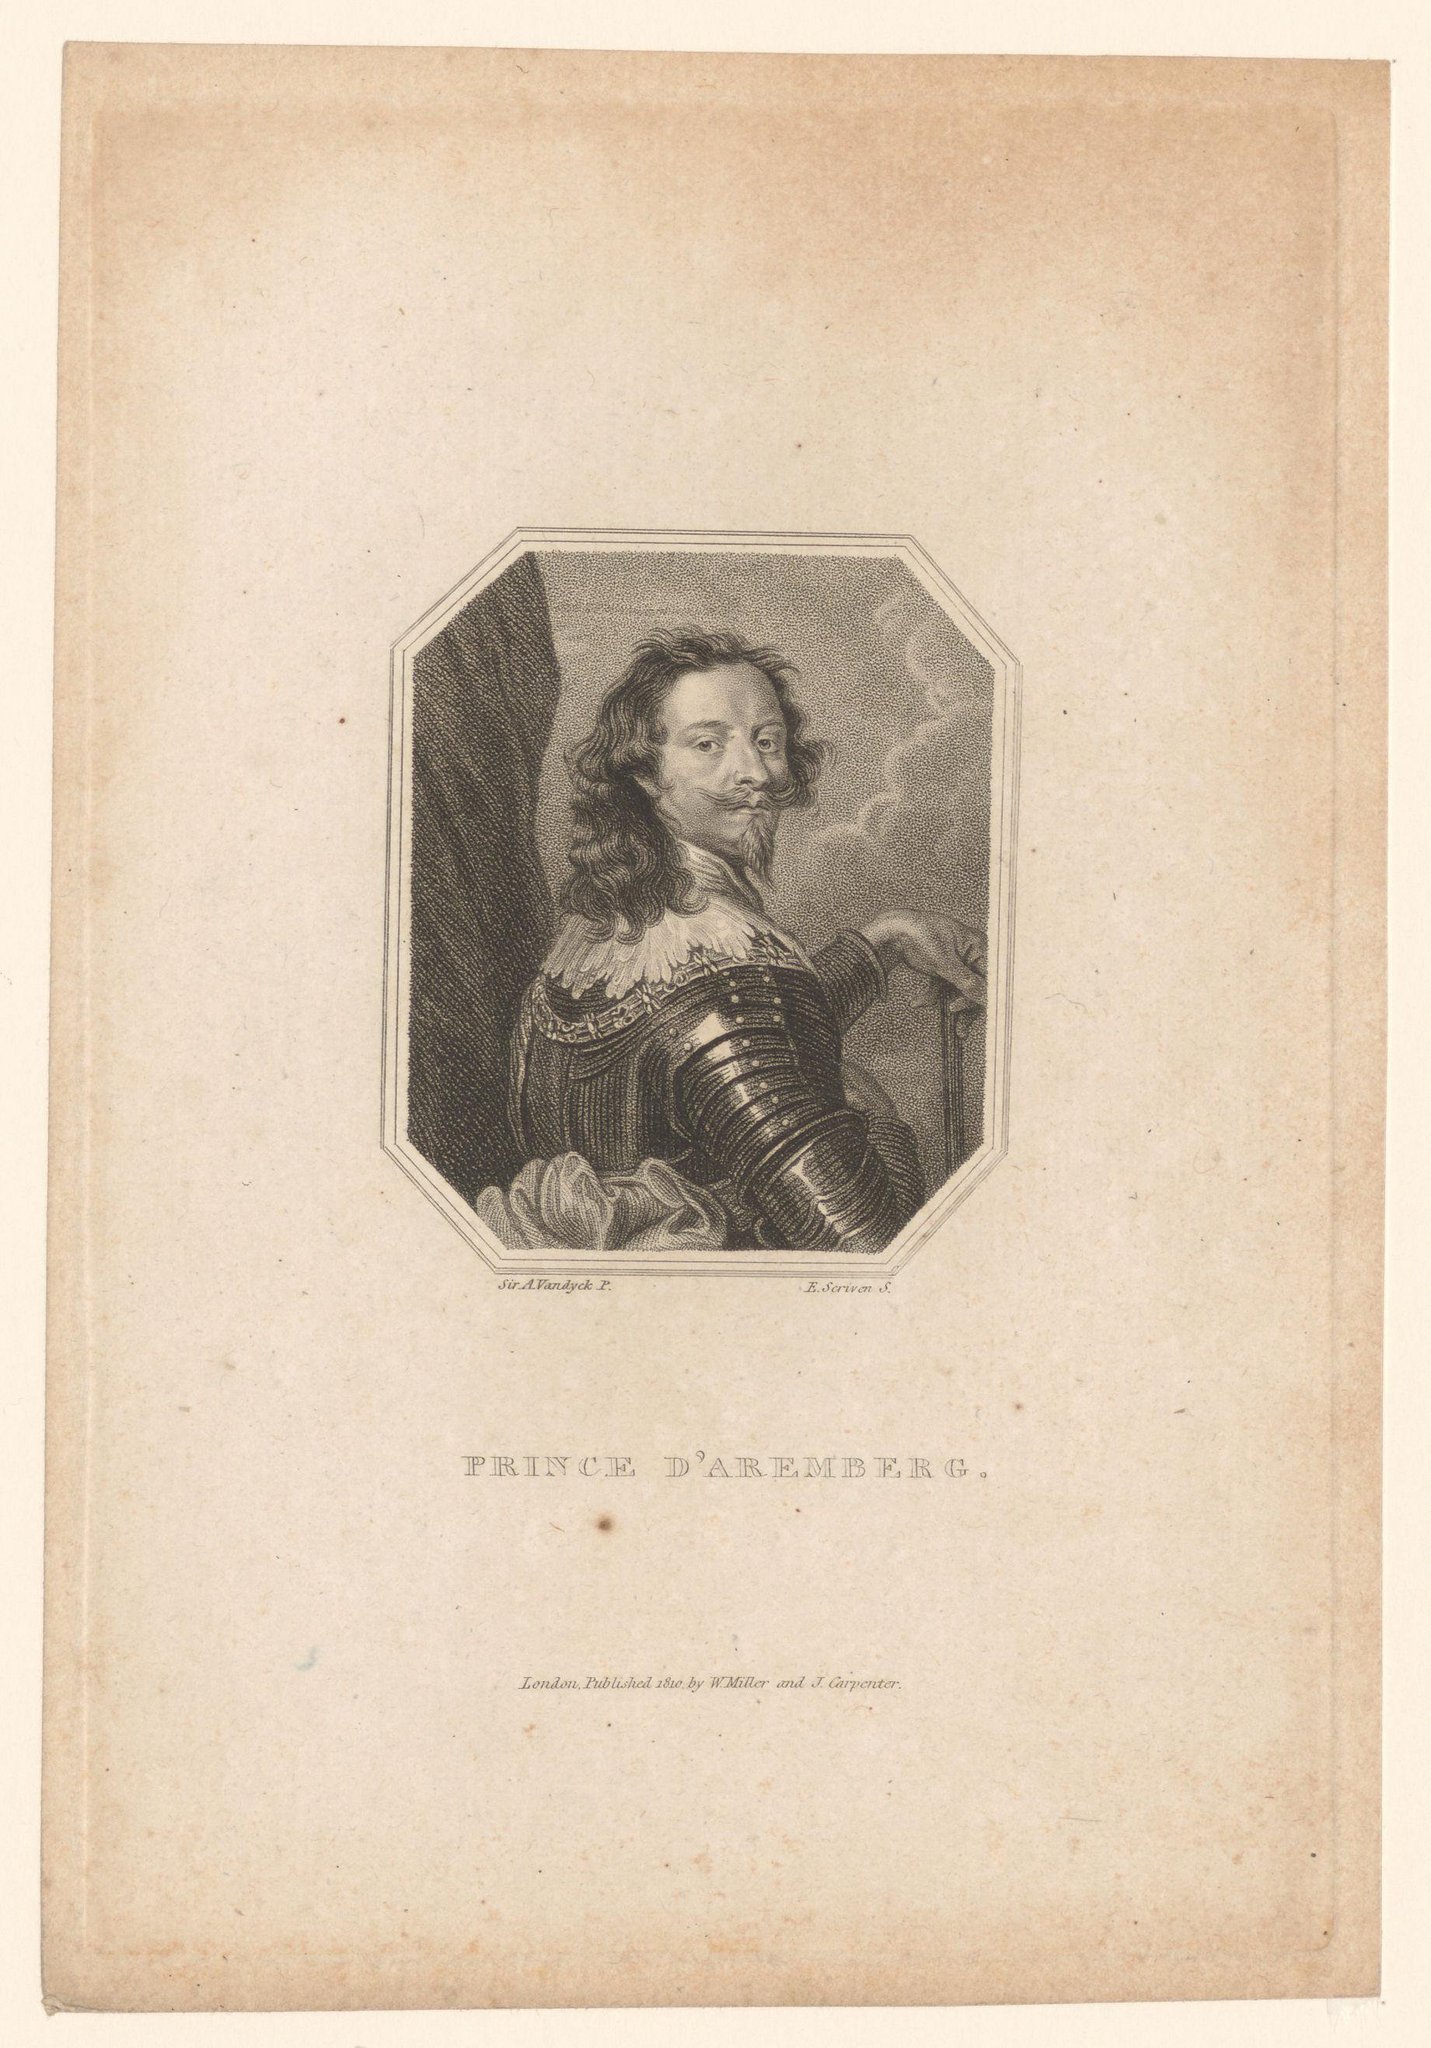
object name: print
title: Portret van Albert de Ligne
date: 1810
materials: paper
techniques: engraving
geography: london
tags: albert de ligne (prins van barbançon en arenberg), historical persons, officer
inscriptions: collector's mark: Lugt 2228